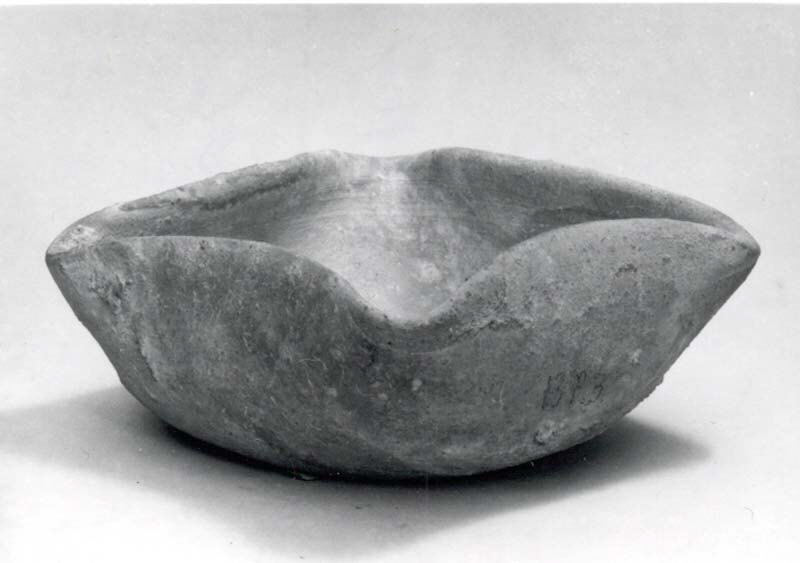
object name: lamp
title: Oil lamp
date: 1900 BCE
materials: ceramic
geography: levant